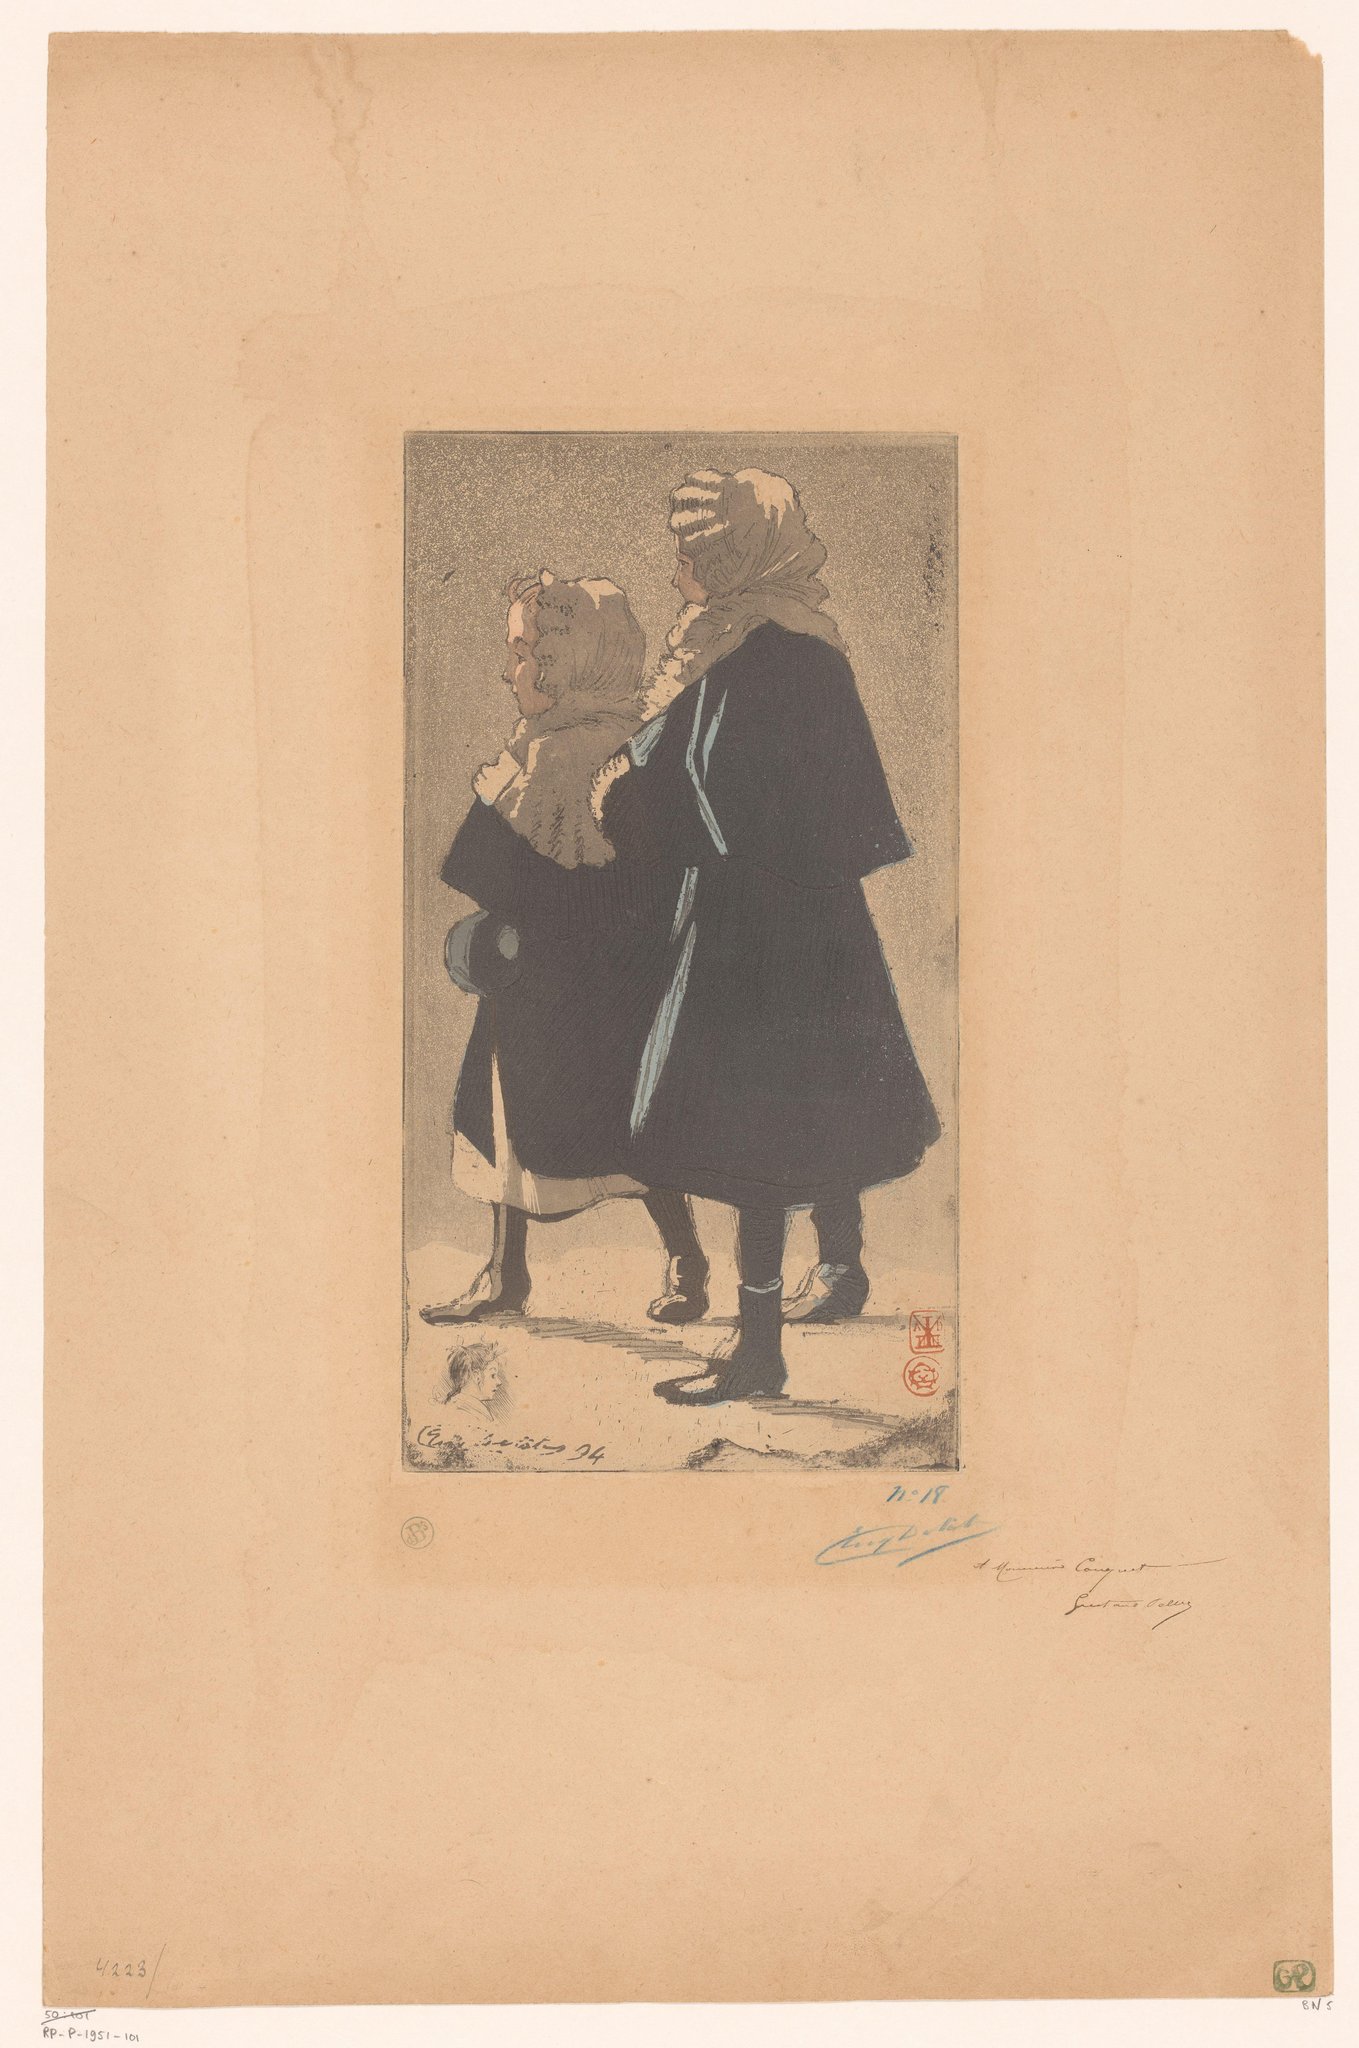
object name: print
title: Twee meisjes in winterkleding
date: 1894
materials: paper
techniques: etching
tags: muff, girl (child between toddler and youth)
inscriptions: collector's mark: Lugt 1190, stamp: Lugt 742, collector's mark: Lugt 2228, collector's mark: Lugt 733, stamp: Lugt 104